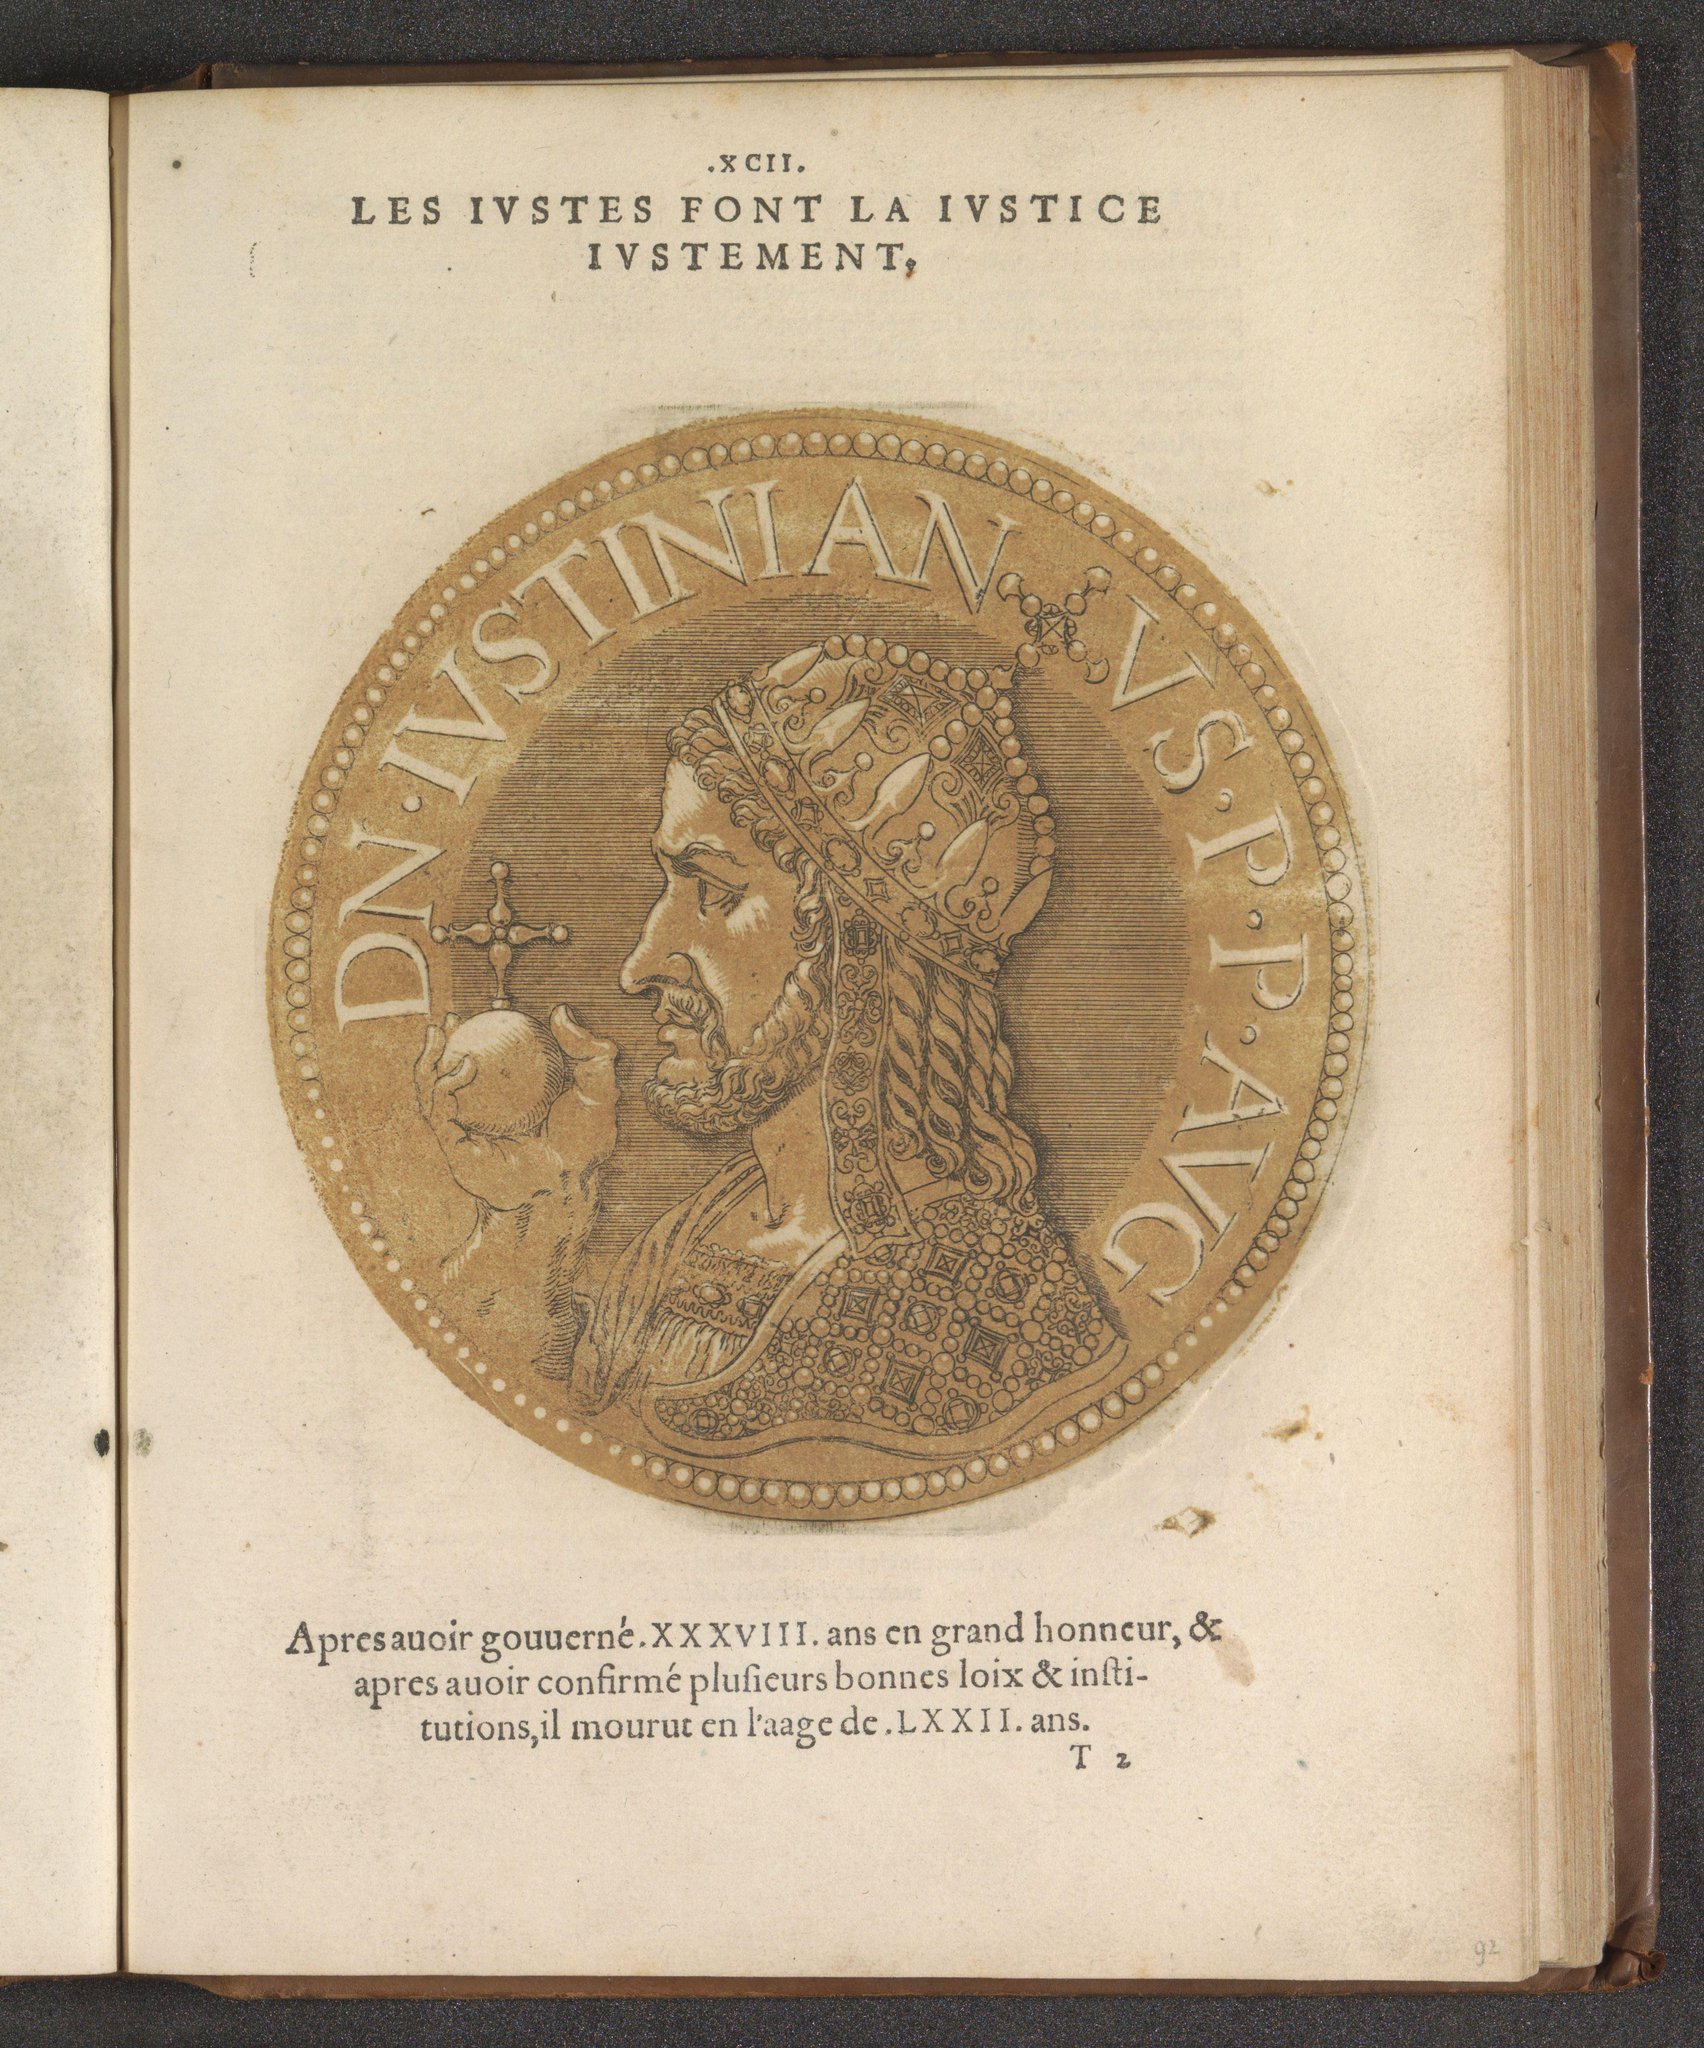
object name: print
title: Les images presque de tous les empereurs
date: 1557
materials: paper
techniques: woodcut, etching, letterpress printing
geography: antwerp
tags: emperor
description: Portret van keizer Justinianus I, op een munt met randschrift. De prent maakt deel uit van een boek over de keizers vanaf Julius Caesar tot en met Karel V en zijn broer Ferdinand.